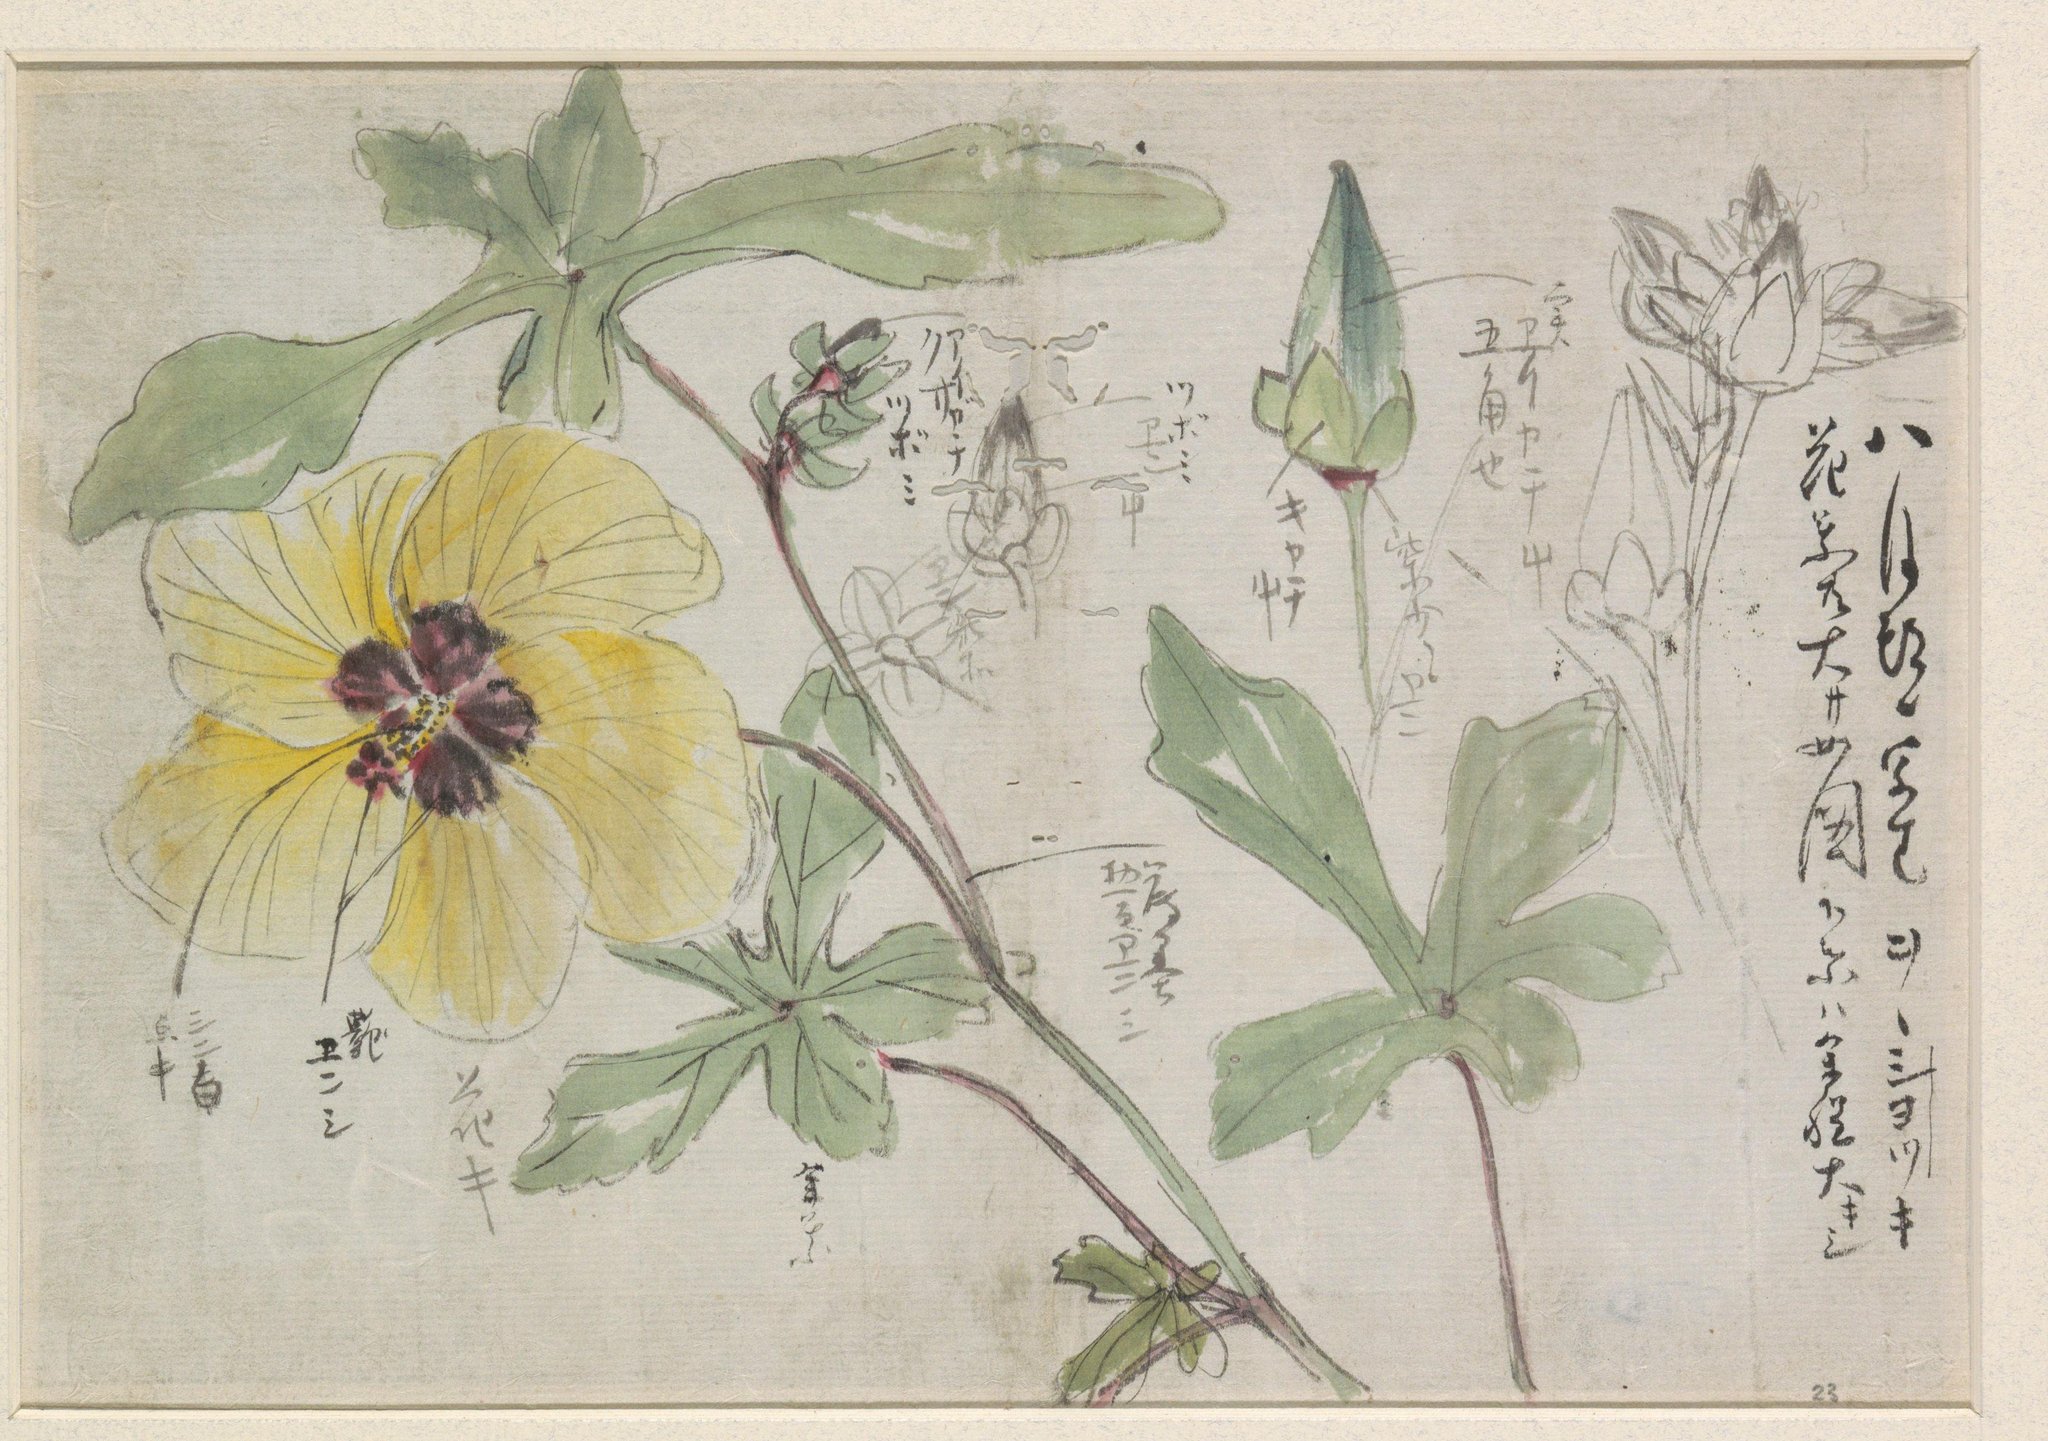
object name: watercolor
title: Schetsblad met malve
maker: ishikawa kazan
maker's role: draughtsman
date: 1800-1900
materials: paper, watercolor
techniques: brush